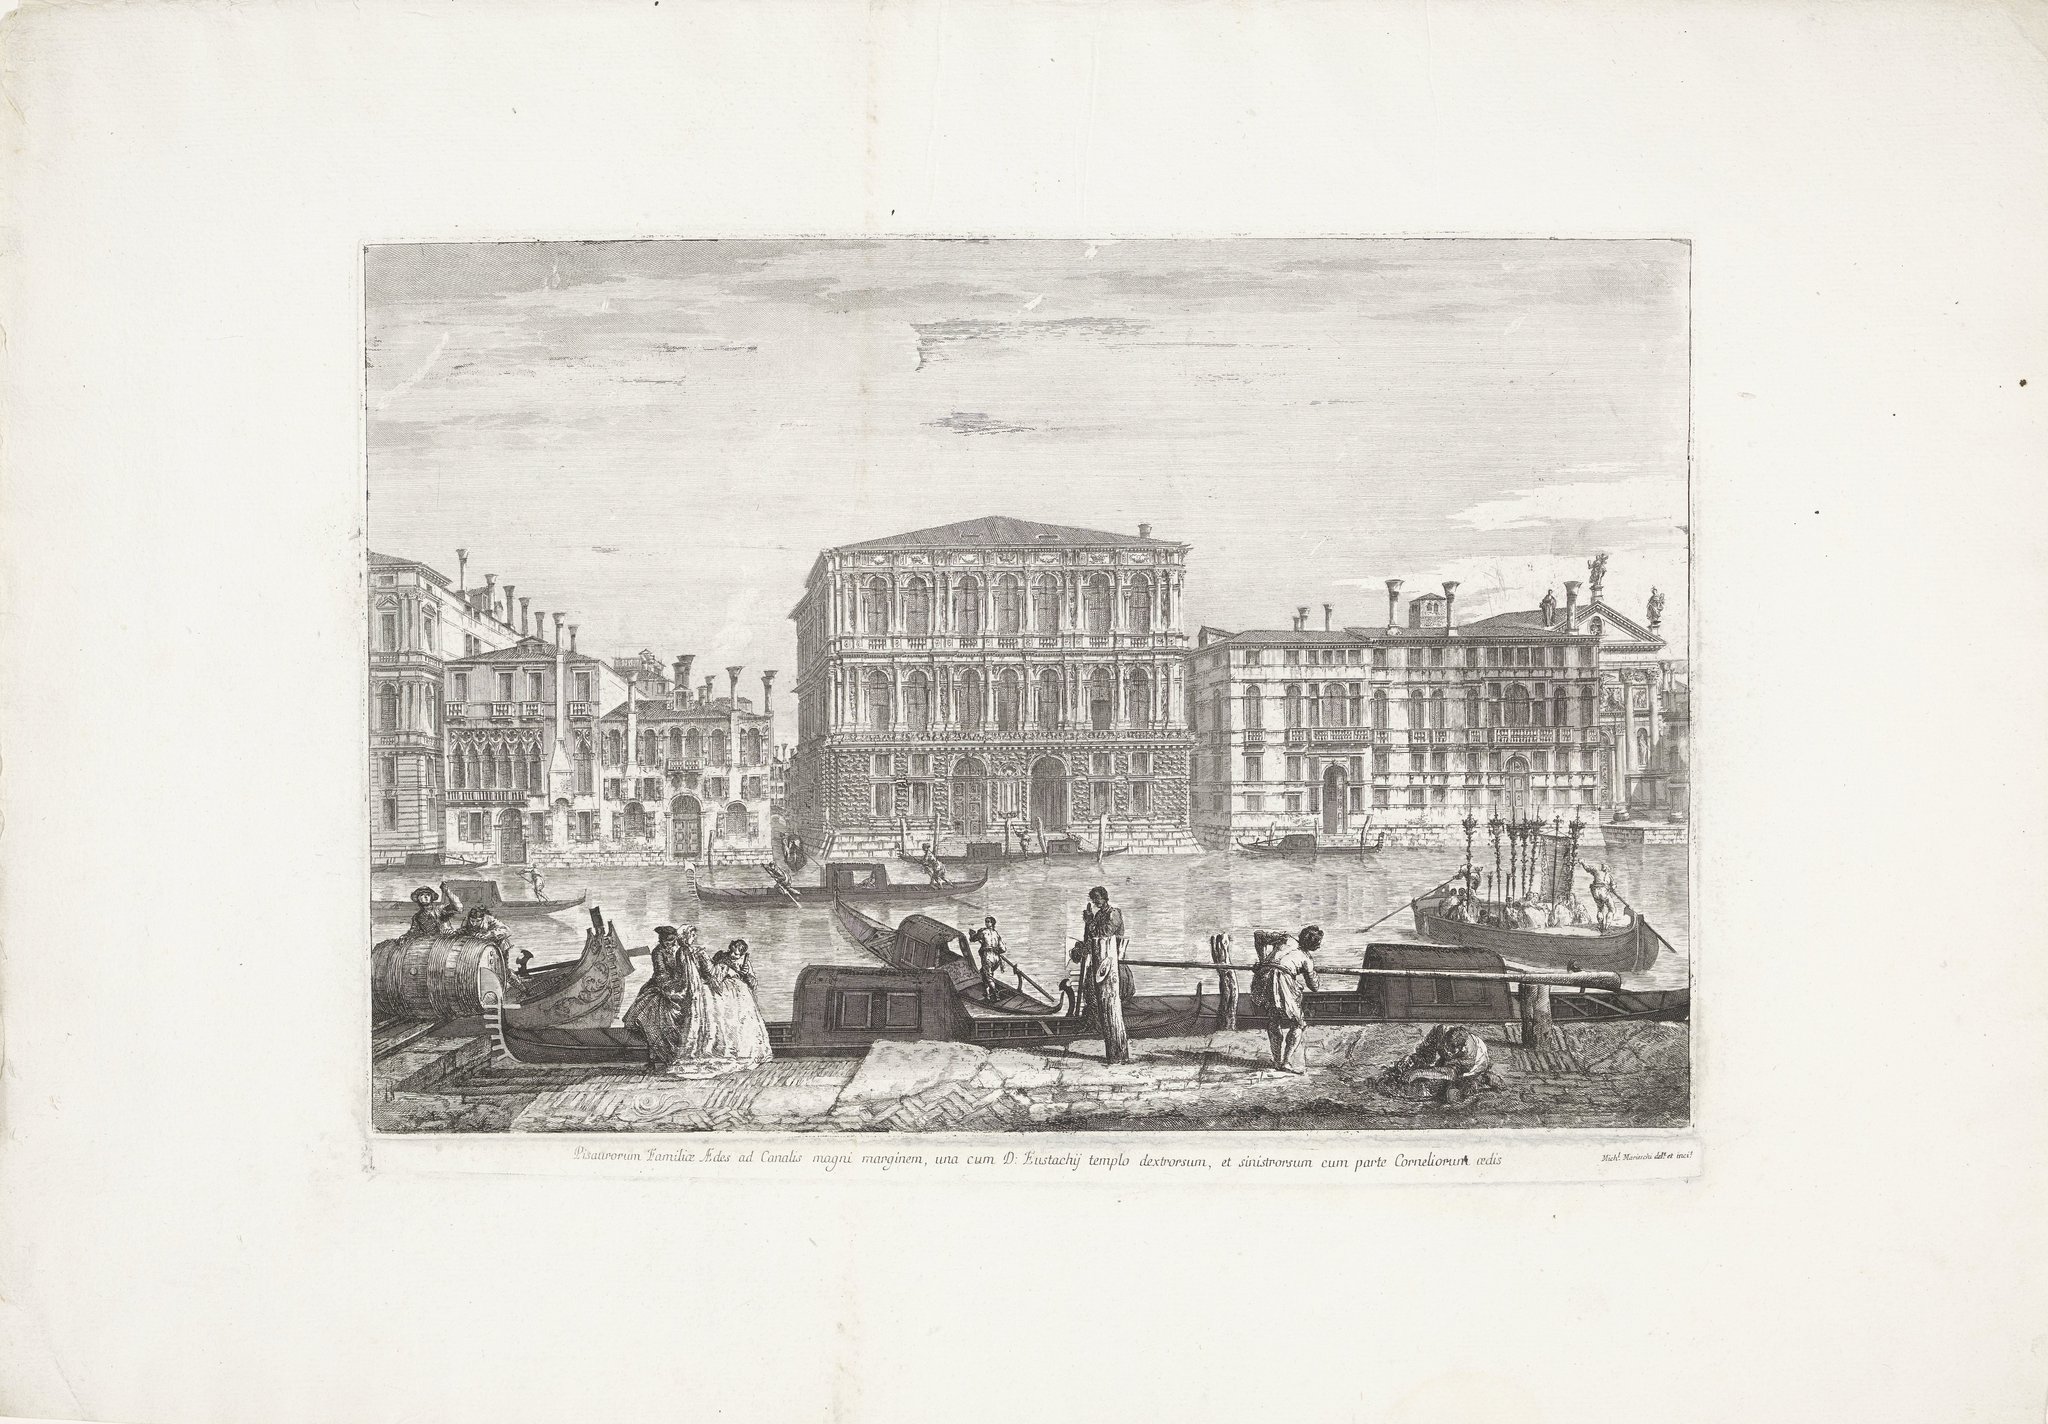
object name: print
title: Ca' Pesaro te Venetië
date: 1741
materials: paper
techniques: engraving, etching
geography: venice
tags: city-view, and landscape with man-made constructions, canal, canals, waters (in city), hôtel, i.e. small palace in city, venice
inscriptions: collector's mark: Lugt 2228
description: Prent maakt deel uit van een reeks van prenten met gezichten op Venetië.